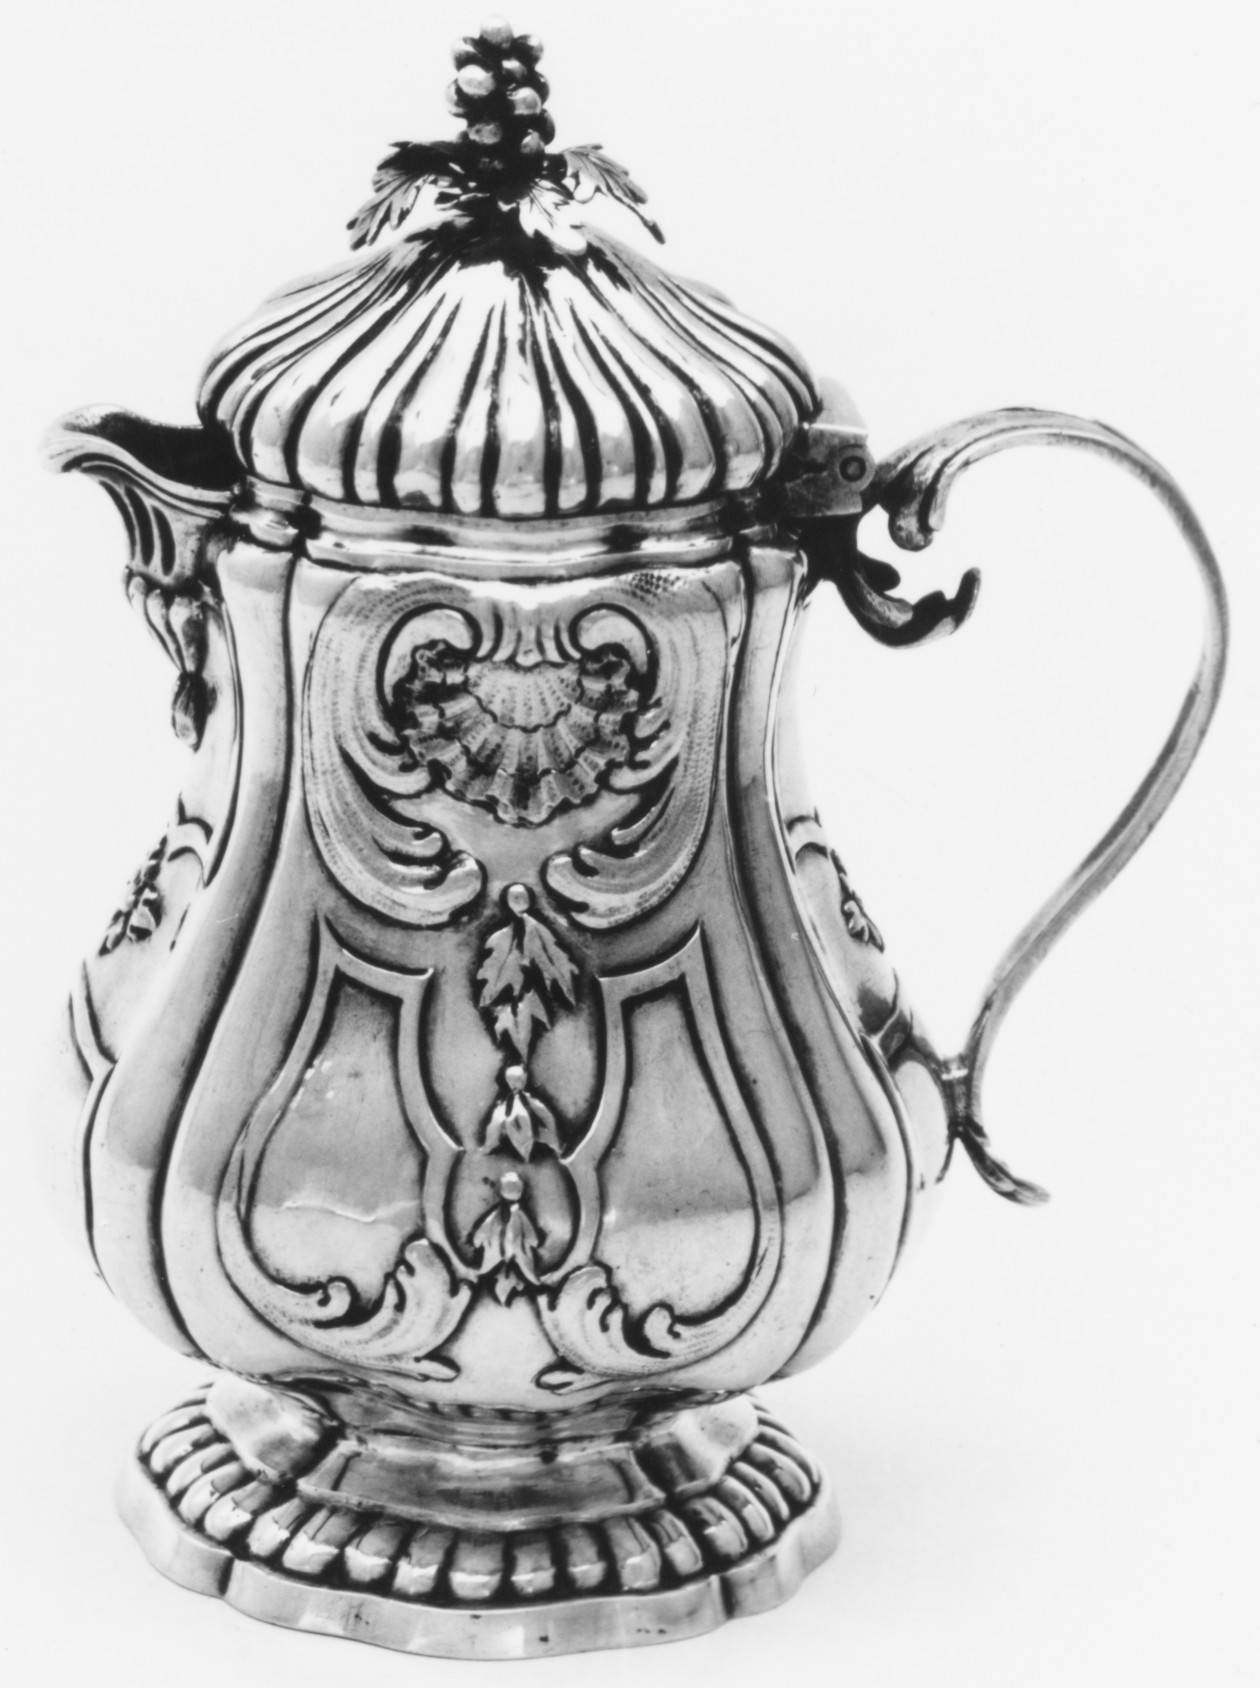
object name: mustard pot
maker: joseph opinel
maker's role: maker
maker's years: 1715-1794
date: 1759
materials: silver